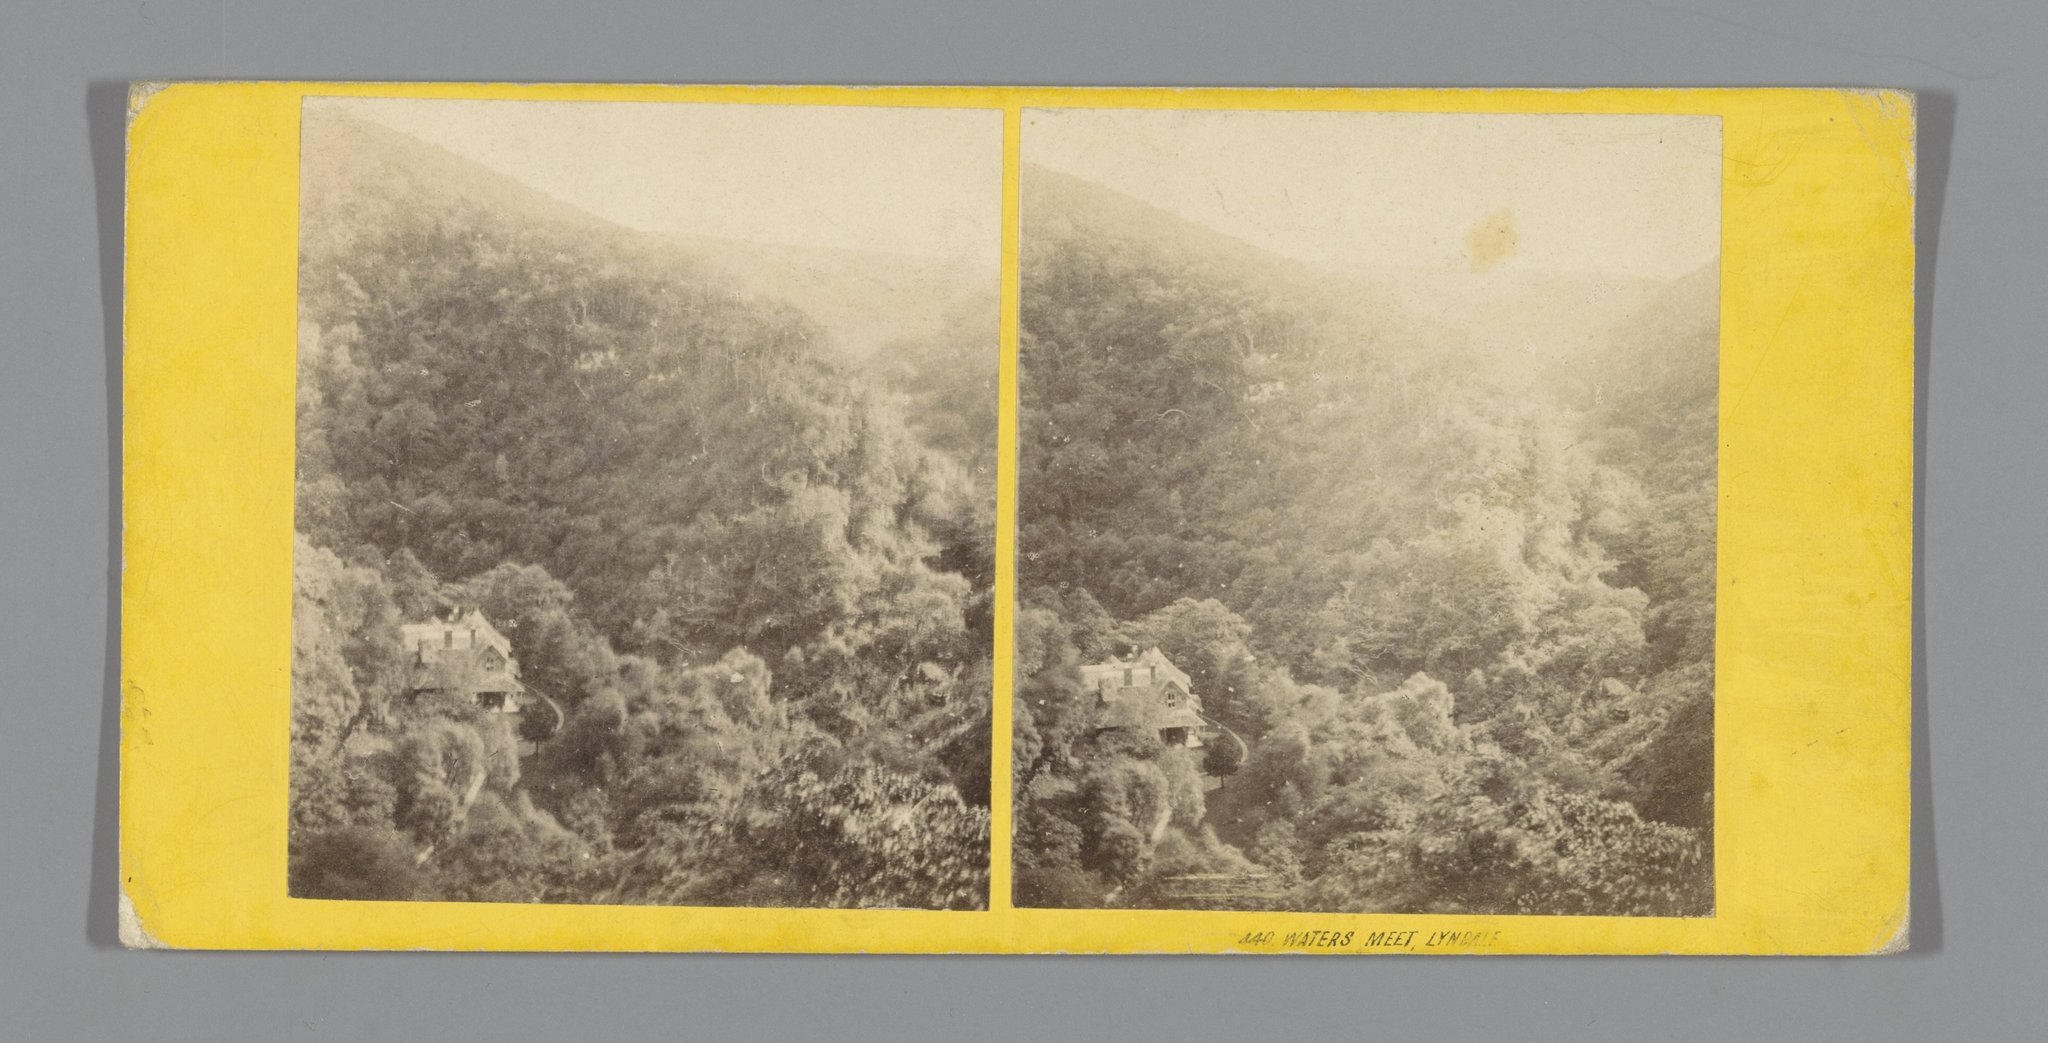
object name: stereograph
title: Gezicht op Watersmeet House te Lynmouth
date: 1850-1880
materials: cardboard, photographic support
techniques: albumen print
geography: lynmouth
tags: dale, valley, rural housing, e.g. country-house, villa, cottage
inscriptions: number: ‘440.’, name: ‘William Spreat, Publisher, 229, High Street, Exeter’